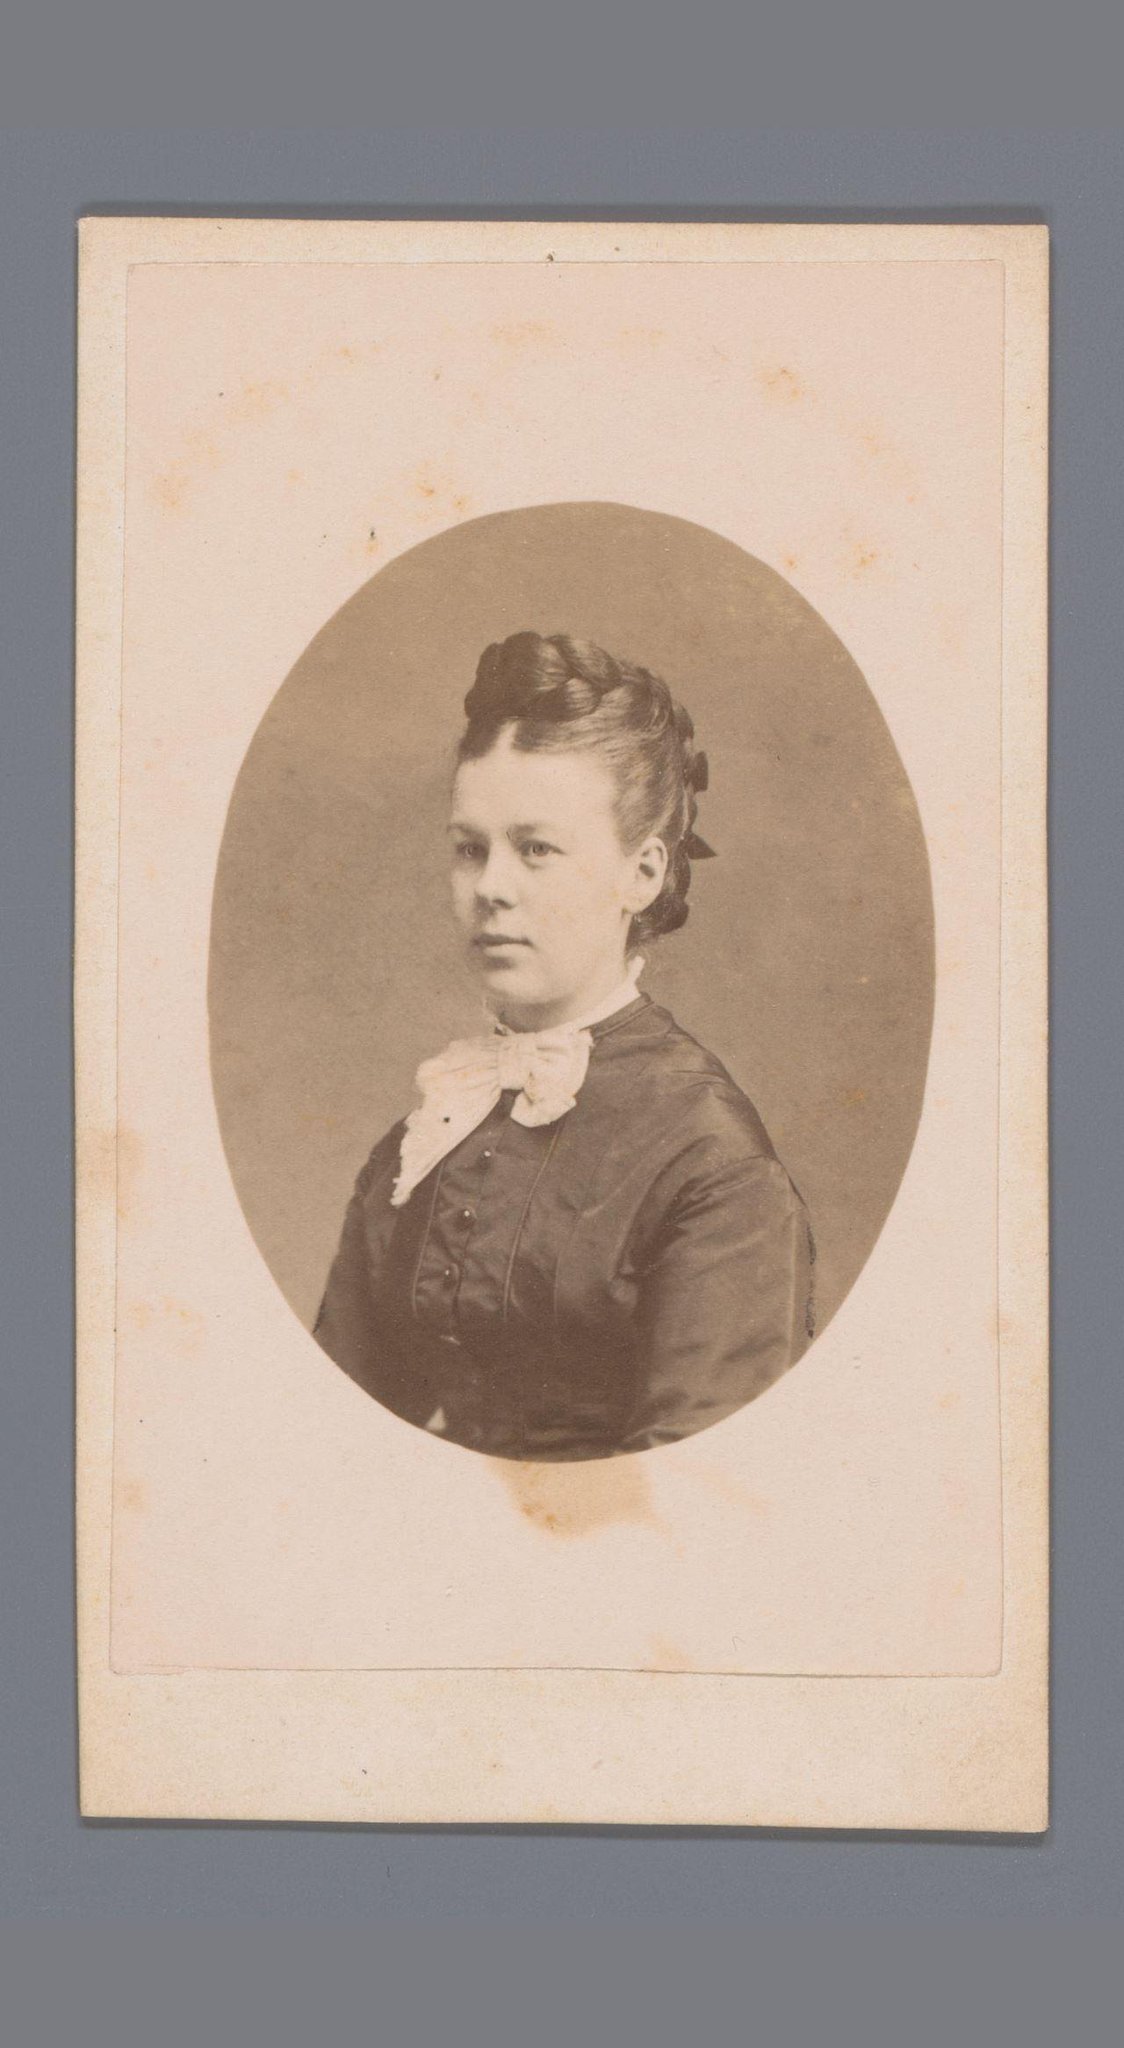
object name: carte de visite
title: Portret van een onbekende vrouw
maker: j. korsten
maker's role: fotograaf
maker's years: 1841-1878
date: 1864-1872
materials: cardboard, paper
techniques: albumen print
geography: middelburg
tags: historical persons - bb - woman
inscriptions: inscription: ‘J. KORSTEN/ kunstschilder/ en/ PHOTOGRAPHE/ MIDDELBURG.’